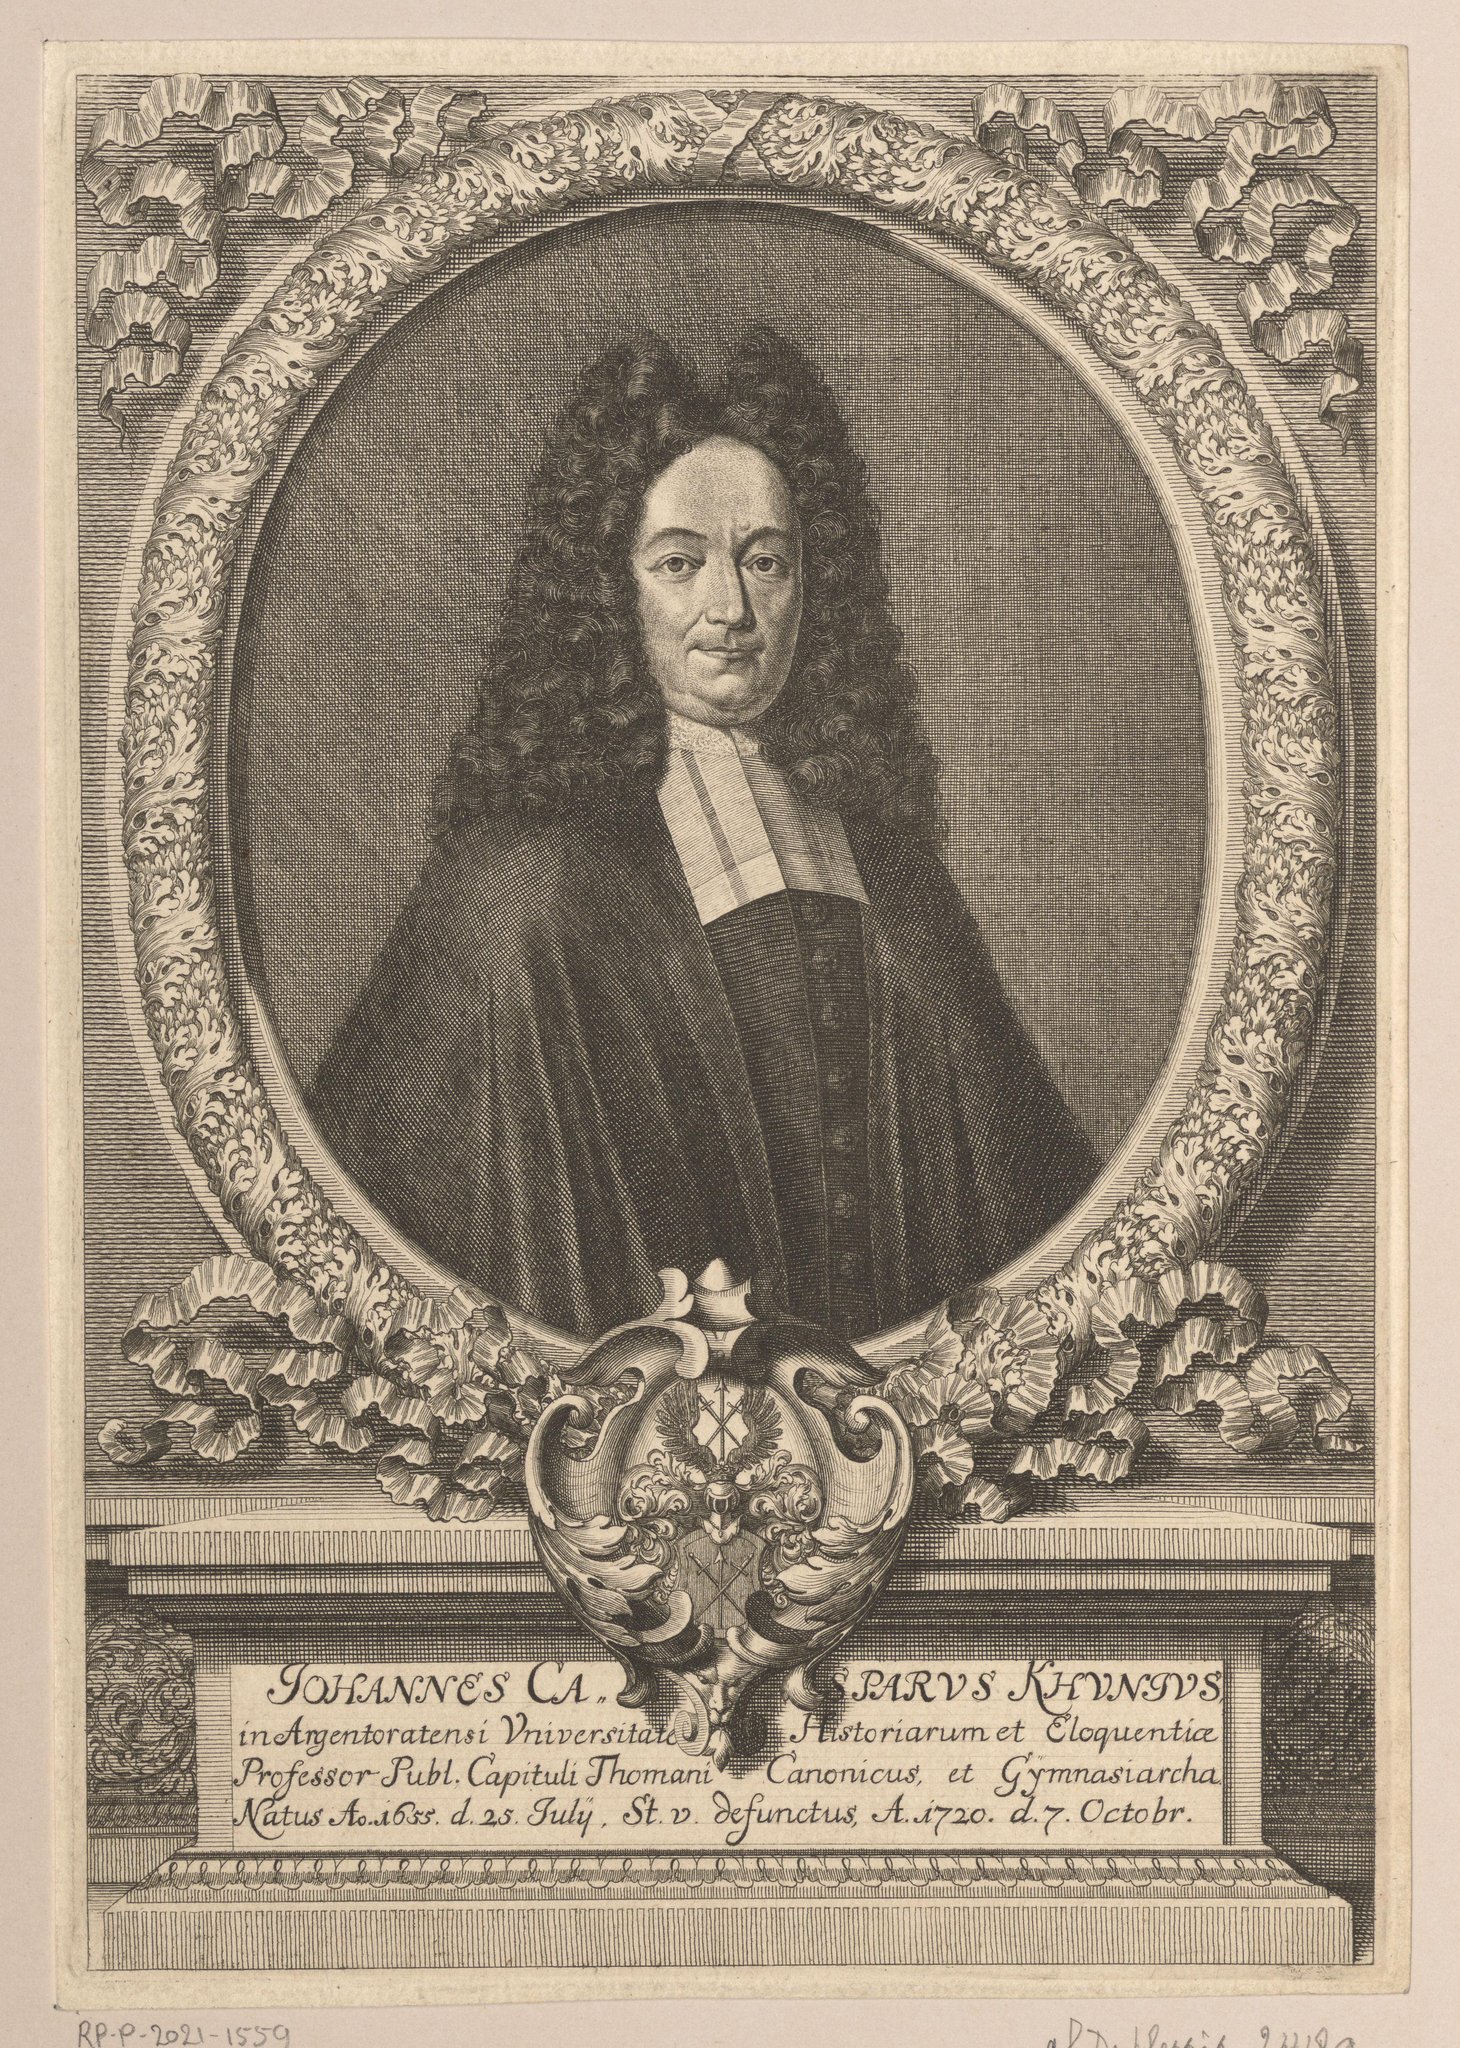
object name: print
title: Portret van Johann Caspar Khun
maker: philipp jacques loutherbourg (i)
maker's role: draughtsman, print maker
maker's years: 1698-1768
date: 1720-1768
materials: paper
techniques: engraving, etching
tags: historical persons, armorial bearing, heraldry